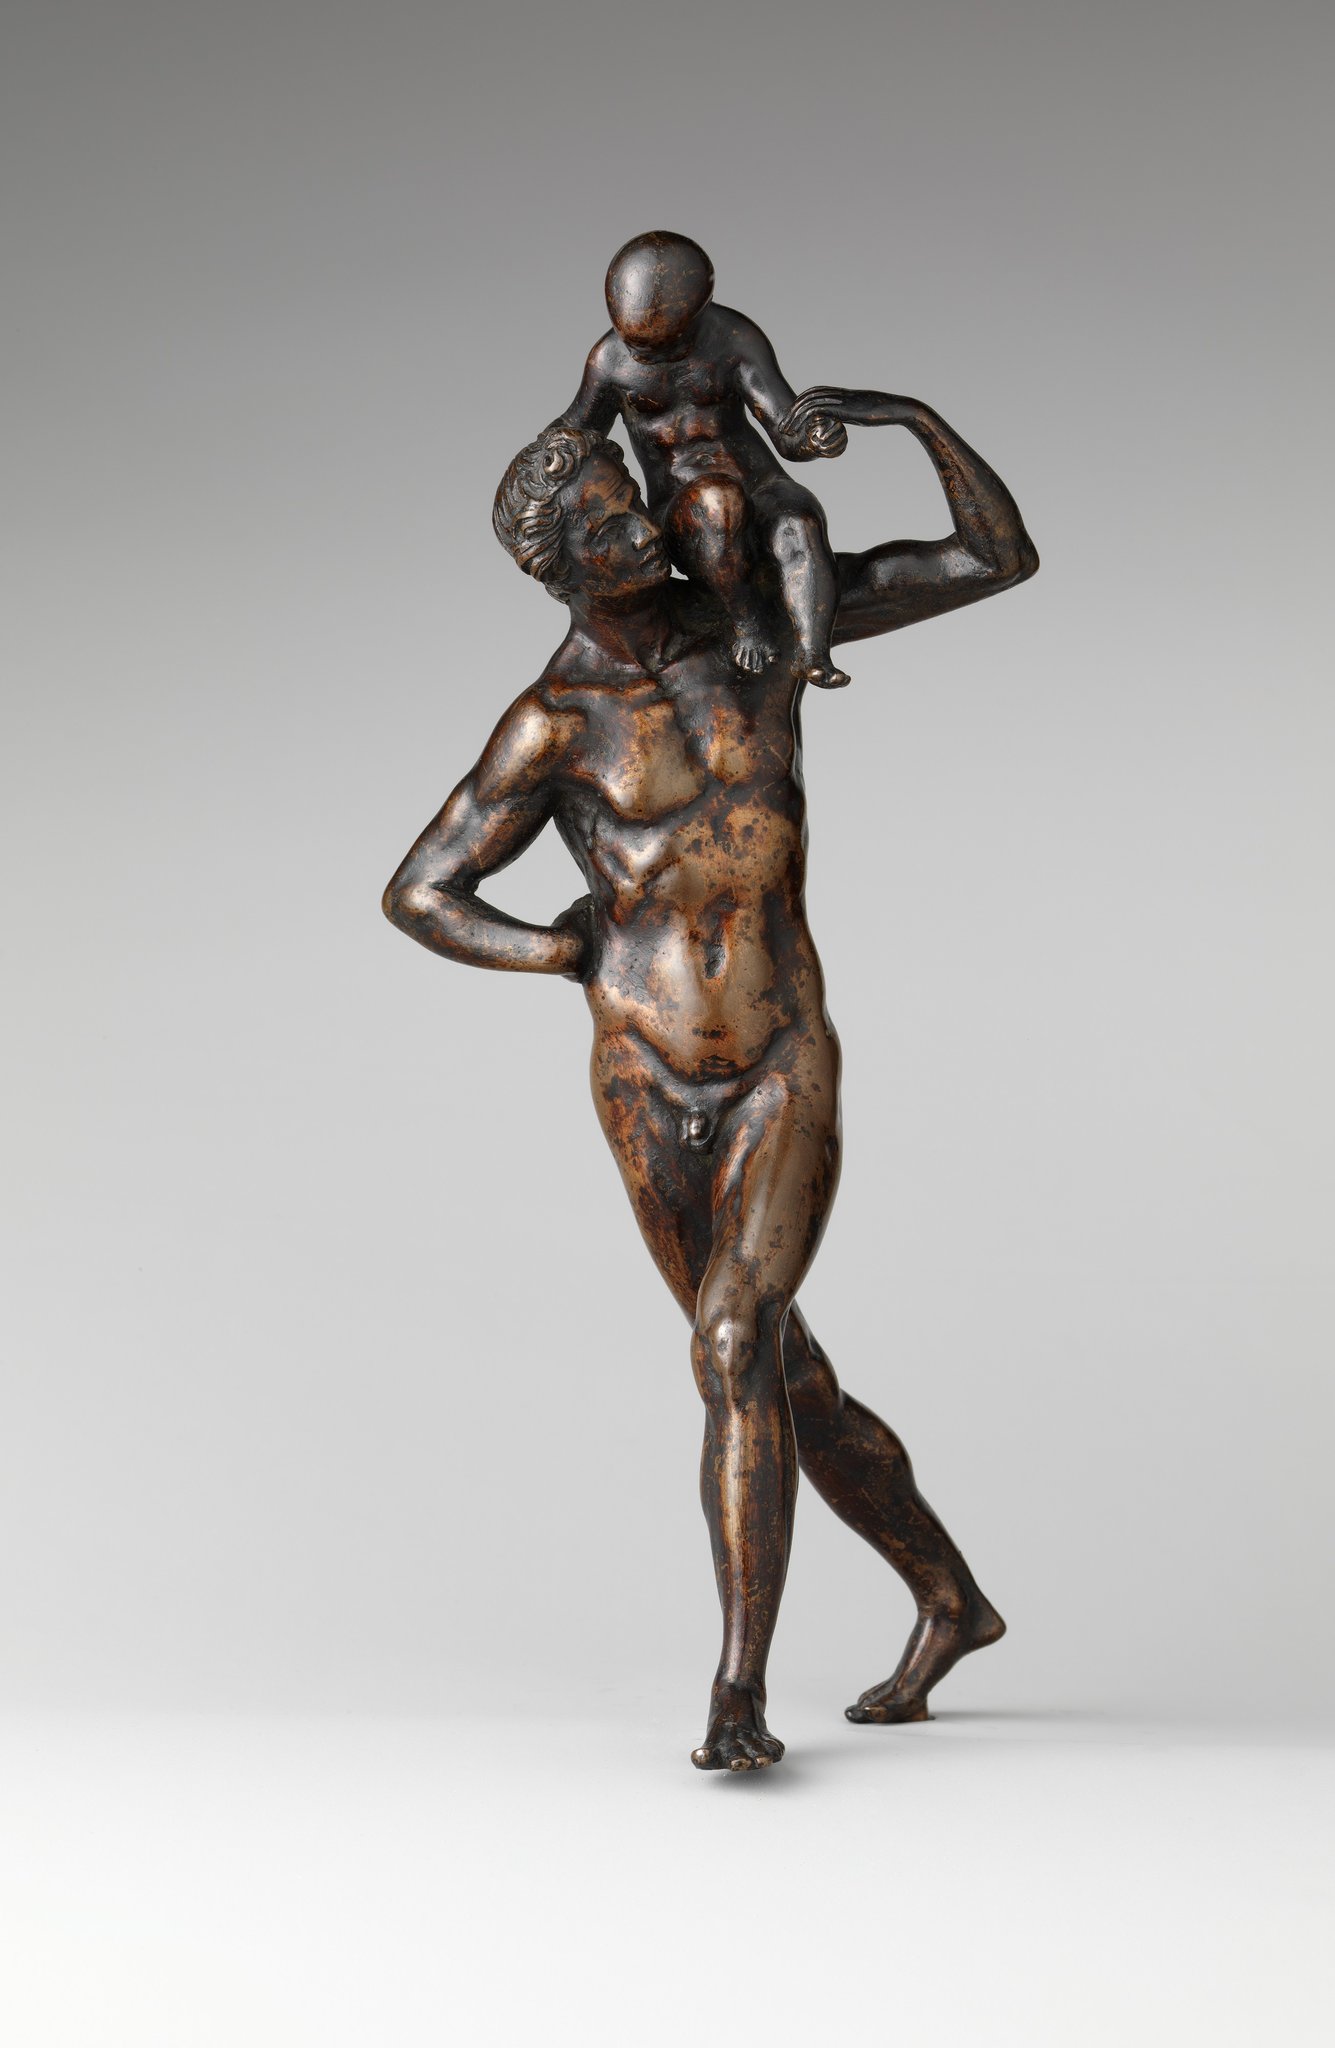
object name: statuette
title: Man Carrying a Child on His Shoulder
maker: barthélemy prieur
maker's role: artist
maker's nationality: french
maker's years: 1536-1611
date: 1567-1633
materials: bronze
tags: children,male nudes